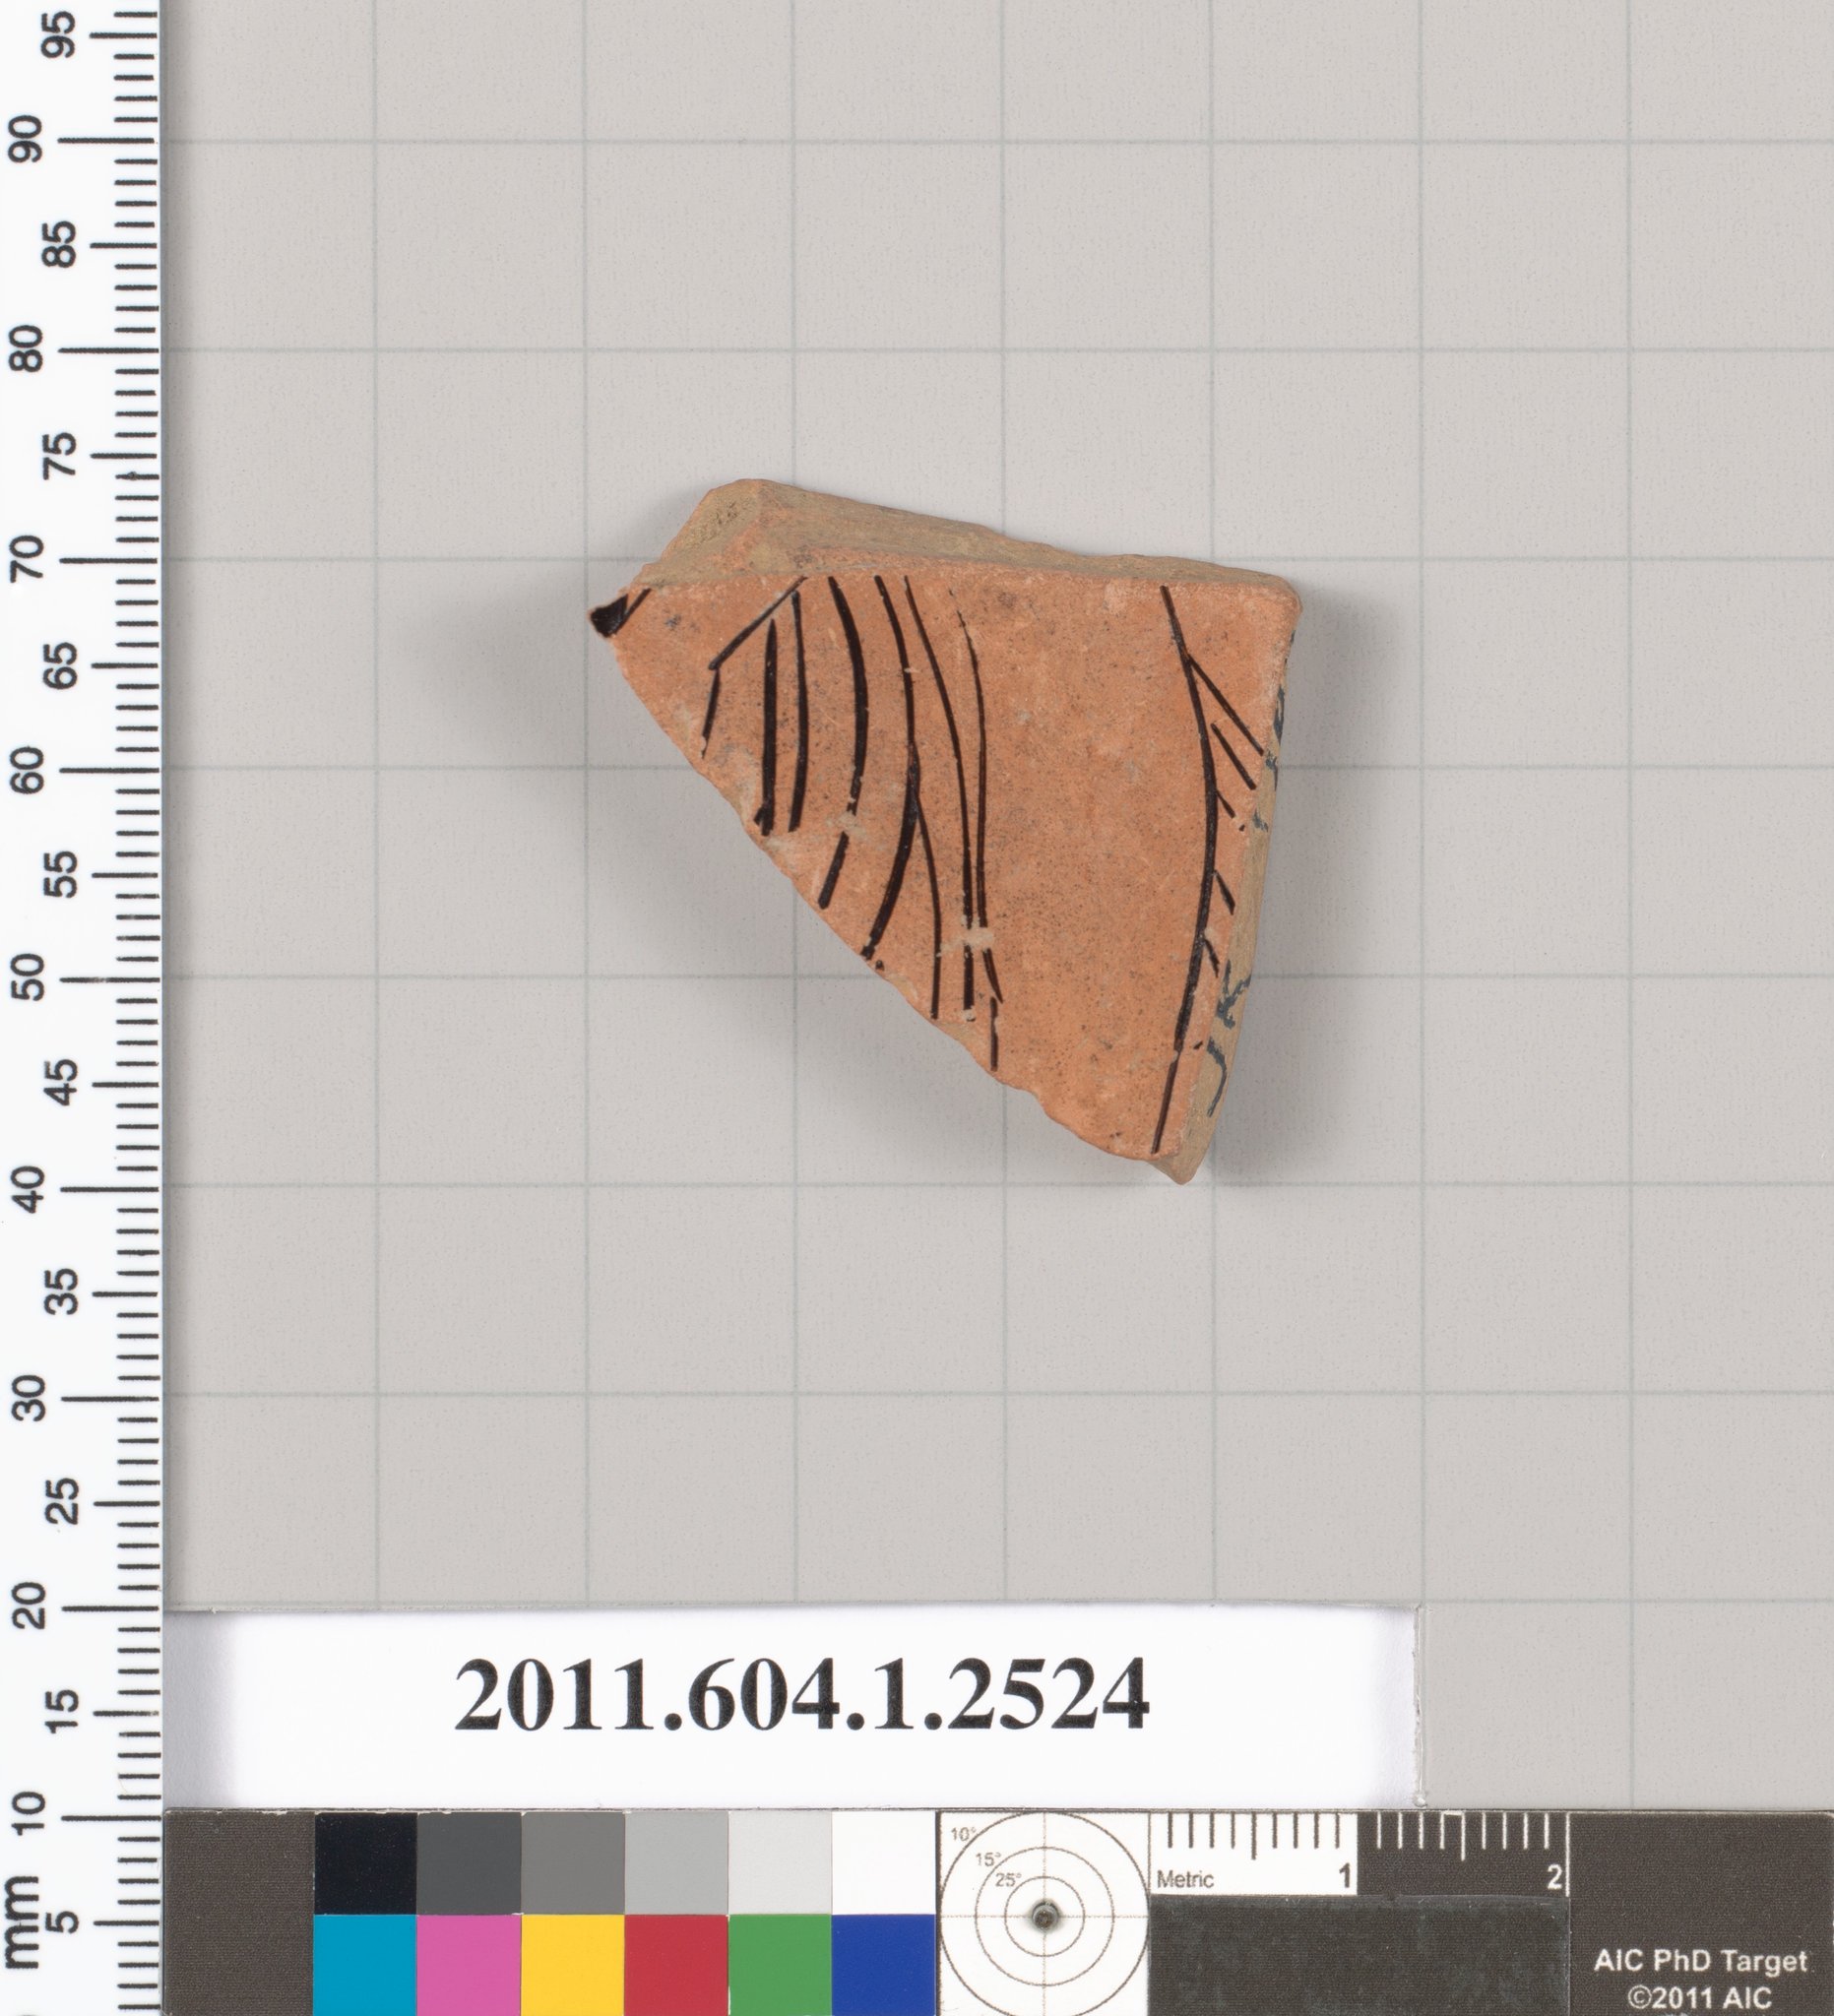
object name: kylix fragment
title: Terracotta fragment of a kylix (drinking cup)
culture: greek, attic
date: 490-480 BCE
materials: terracotta